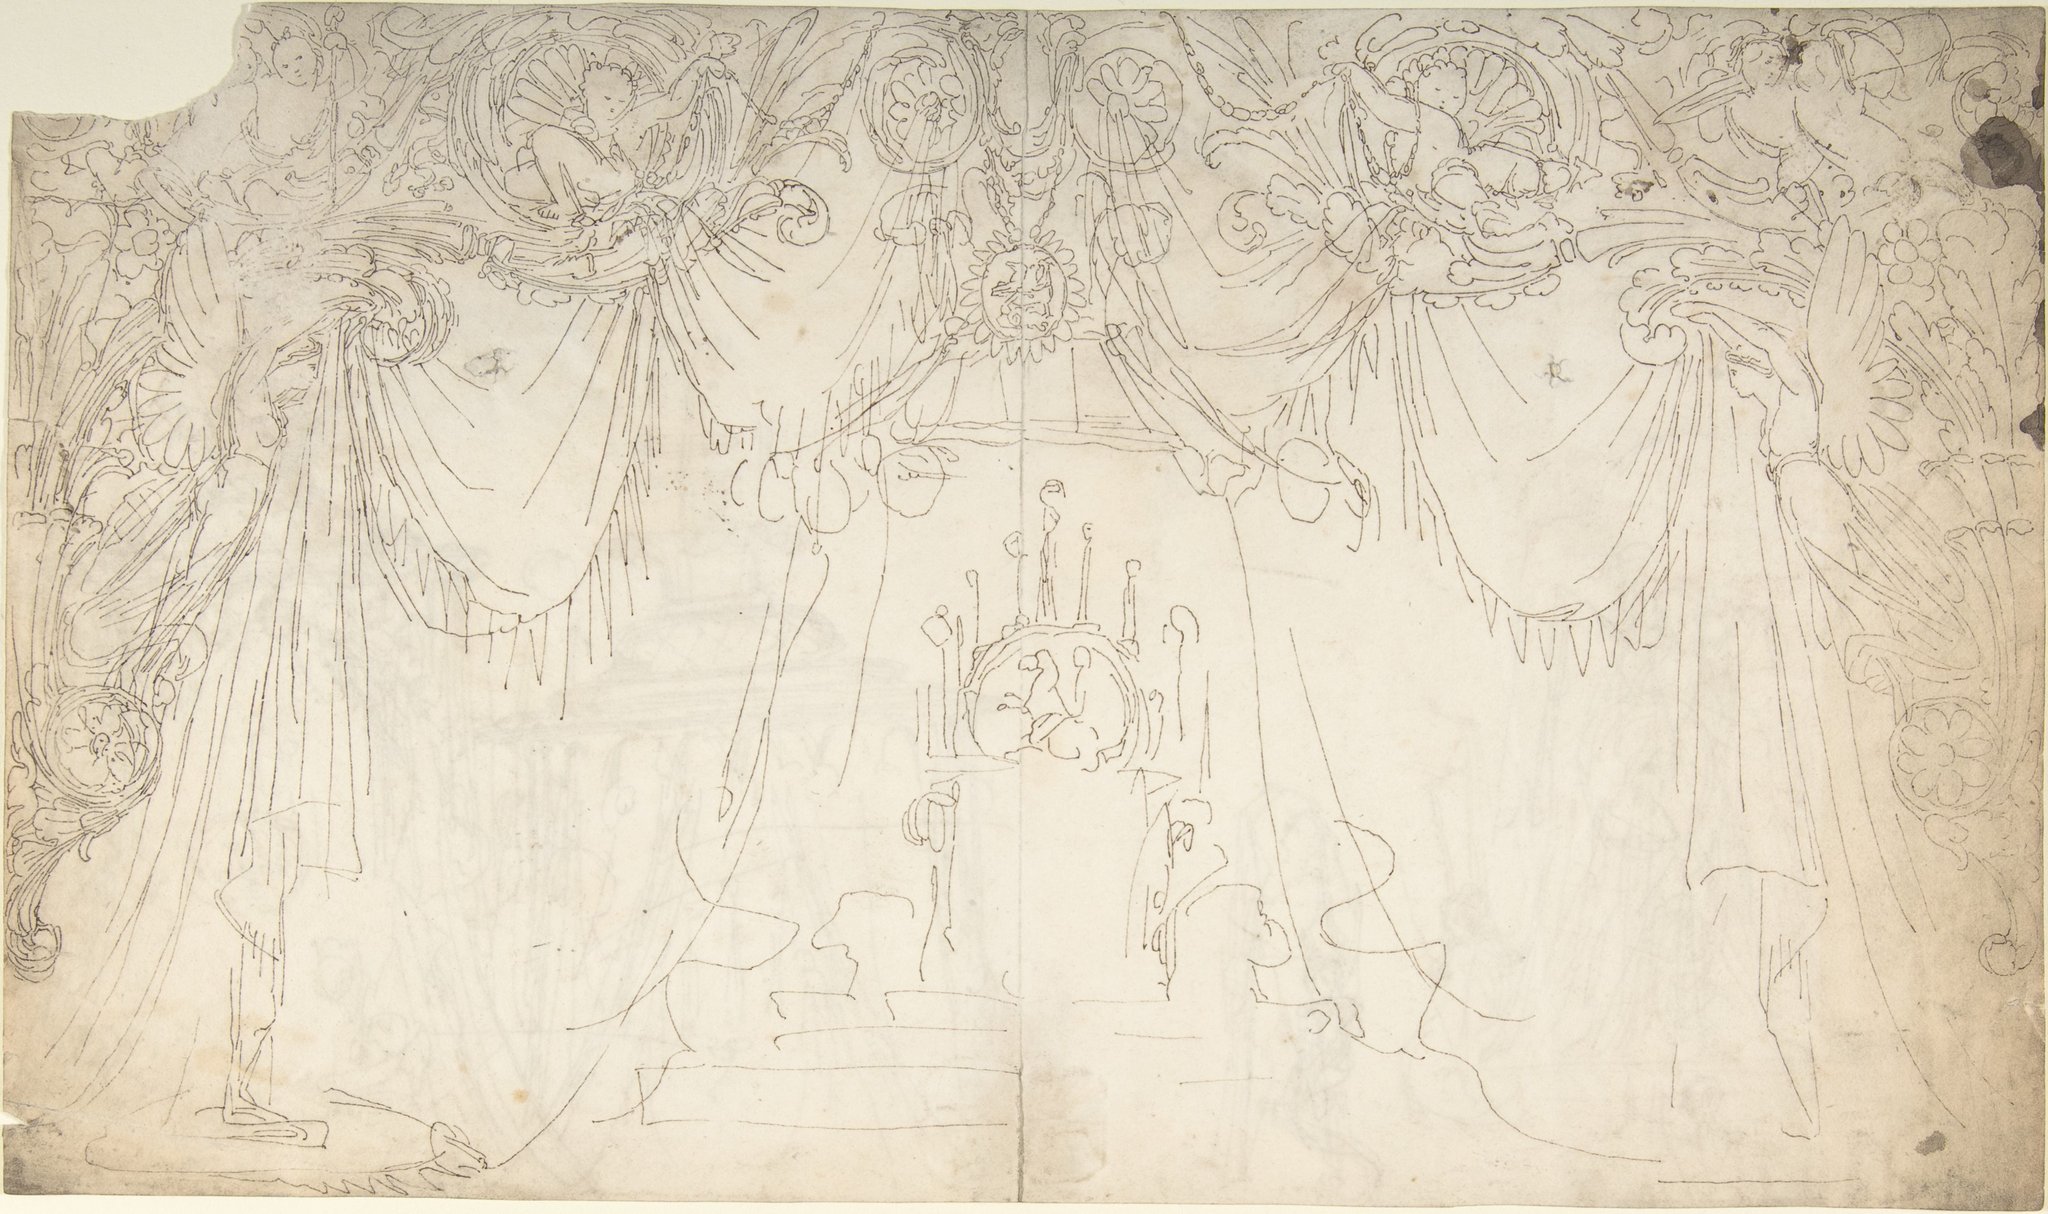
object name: drawing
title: Design for Bed Alcove (recto); Studies for Statues and Carvings on Bed (verso)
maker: william pitts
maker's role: artist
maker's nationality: british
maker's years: 1790-1840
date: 1805-1840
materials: ink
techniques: pen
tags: beds